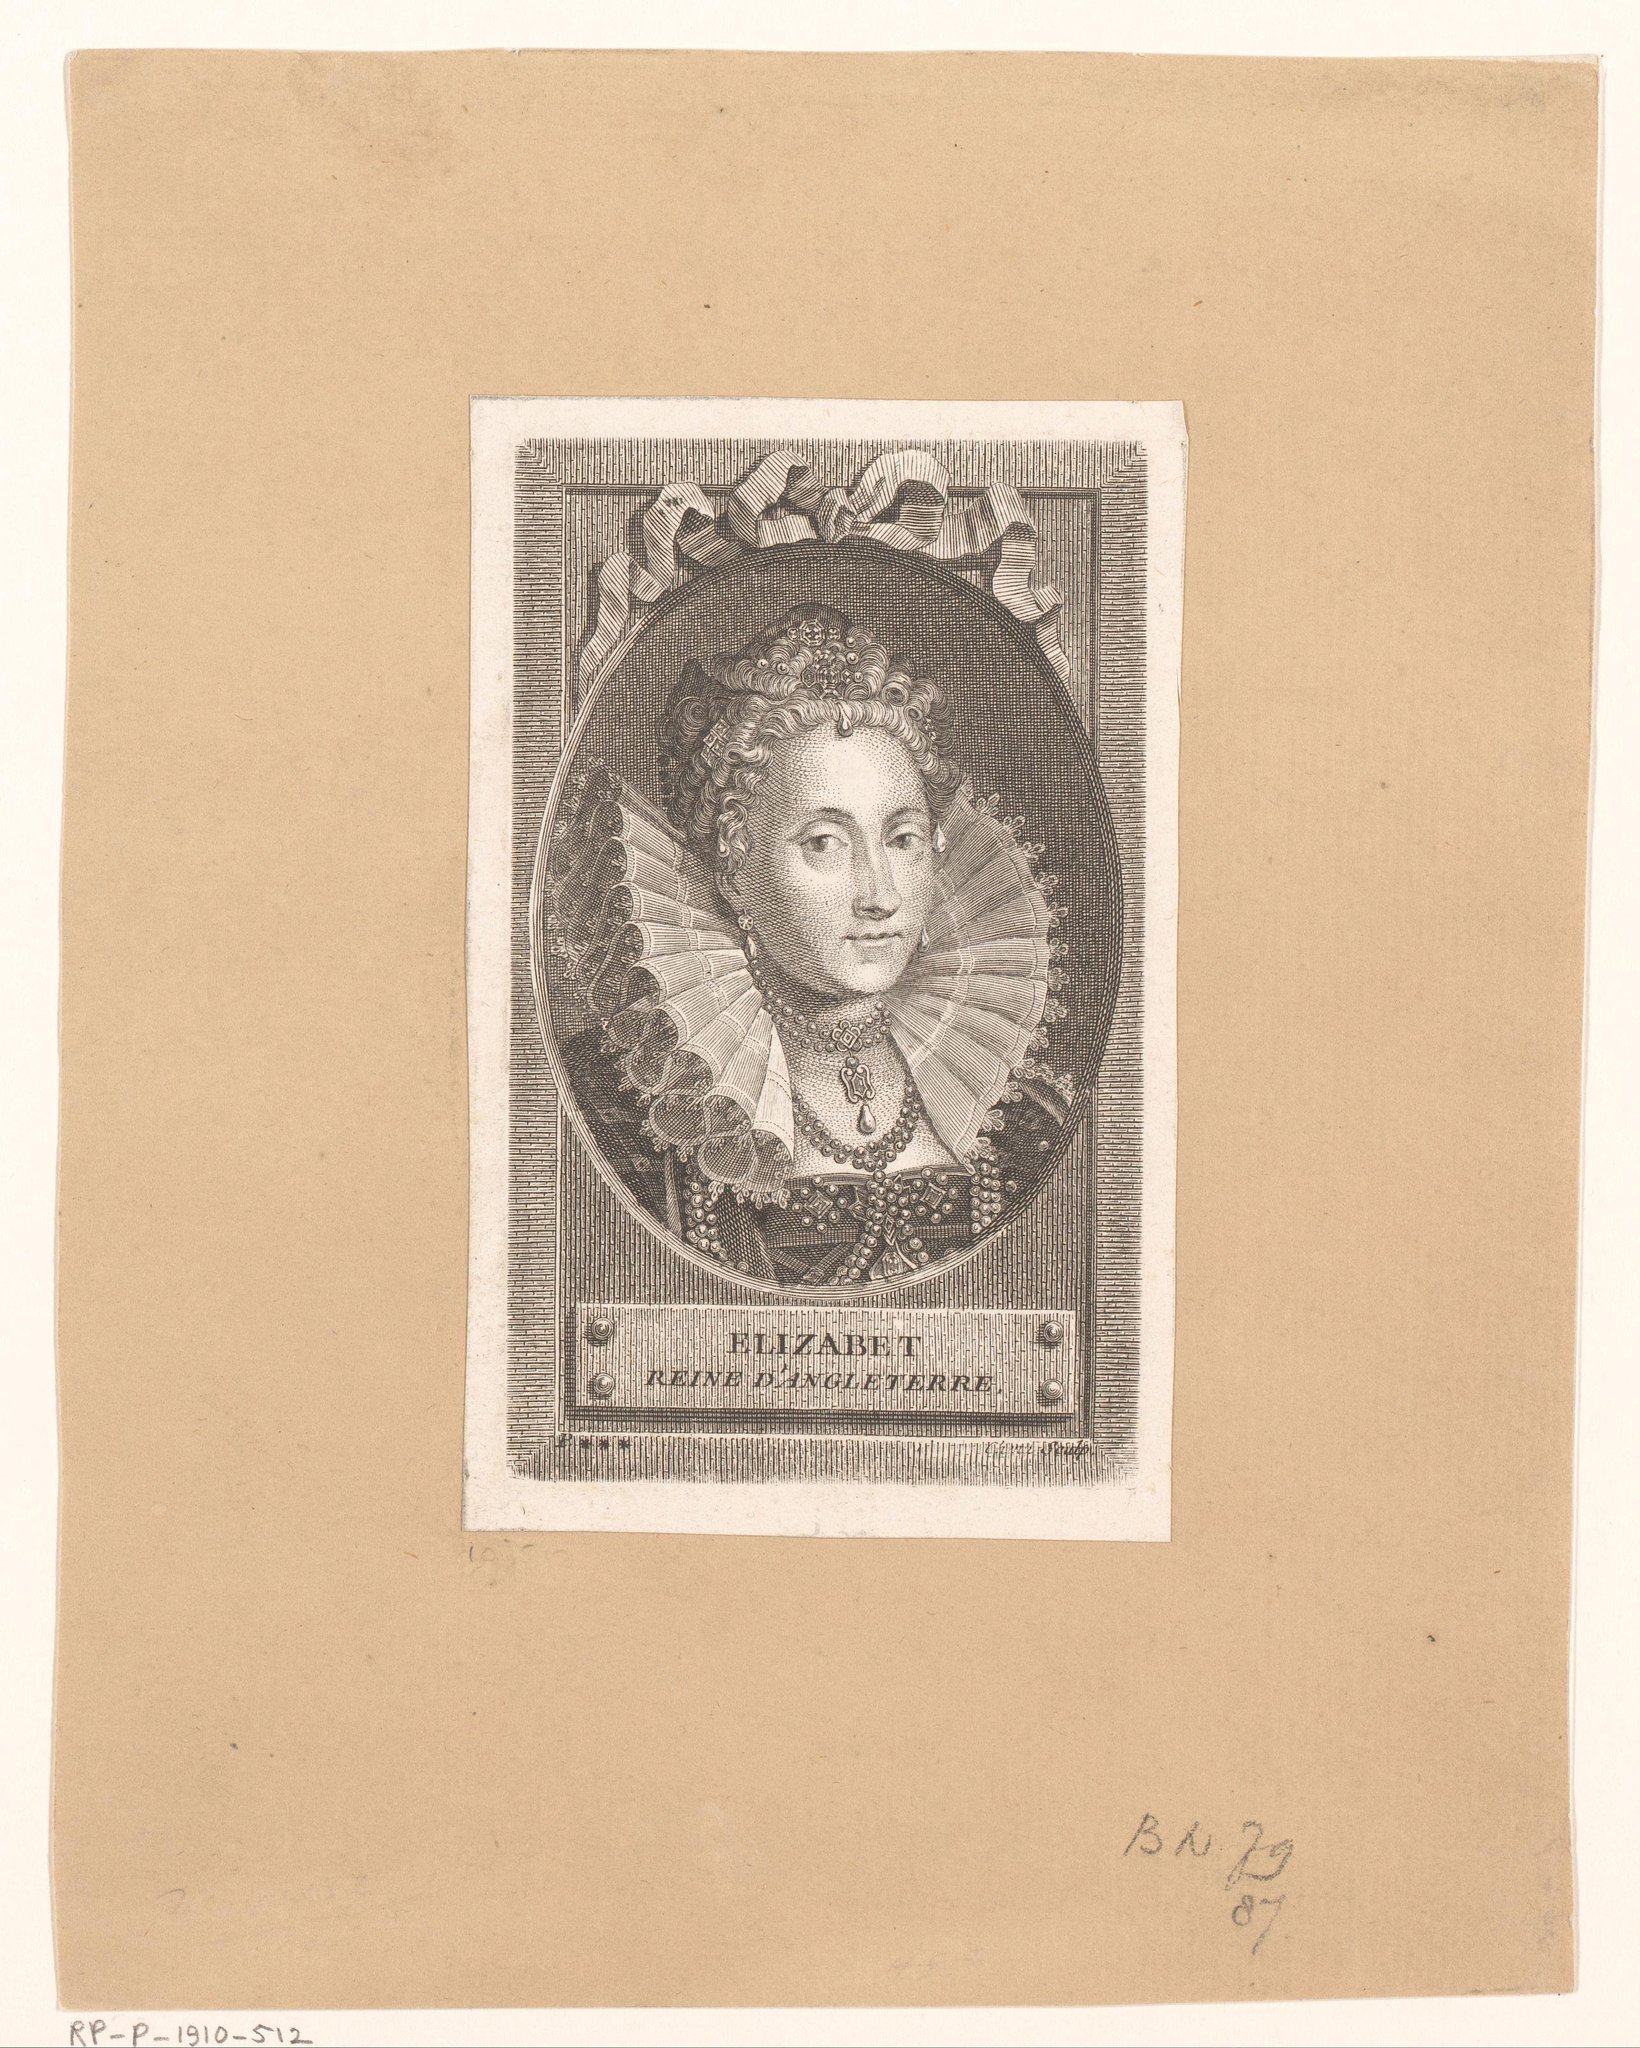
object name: book illustration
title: Portret van Elizabeth I Tudor, koningin van Engeland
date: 1766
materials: paper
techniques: engraving, etching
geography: paris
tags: historical persons, queen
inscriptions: collector's mark: Lugt 2228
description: Prent uit: Bury, Richard de. Histoire de la vie de Henri IV, roi de France et de Navarre (...). Parijs: Saillant, Charles, 1766.